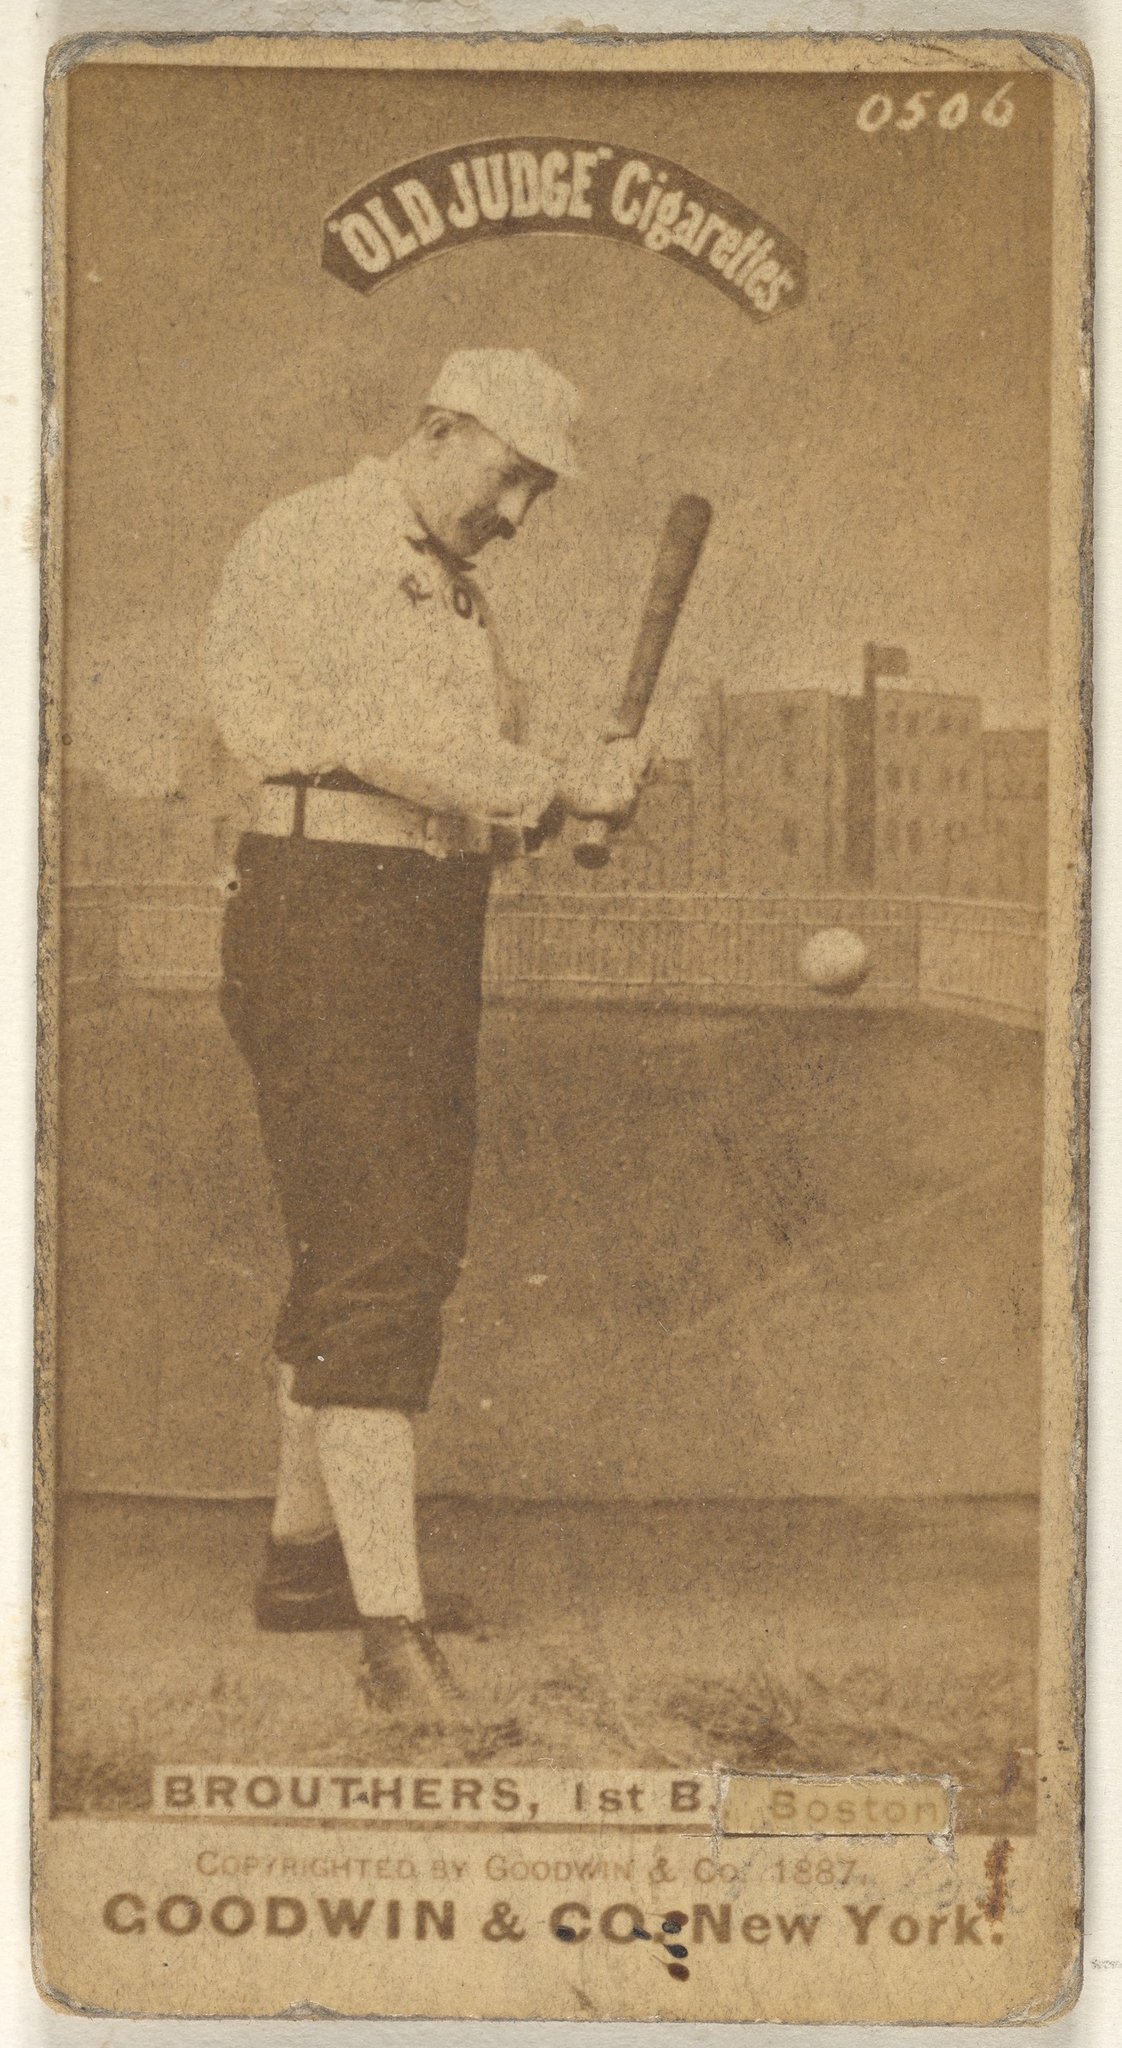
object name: baseball card, photograph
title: Brouthers, 1st Base, Boston, from the Old Judge series (N172) for Old Judge Cigarettes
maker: goodwin & company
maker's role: publisher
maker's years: 1850-1950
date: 1887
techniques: albumen silver print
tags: men,portraits,baseball,athletes